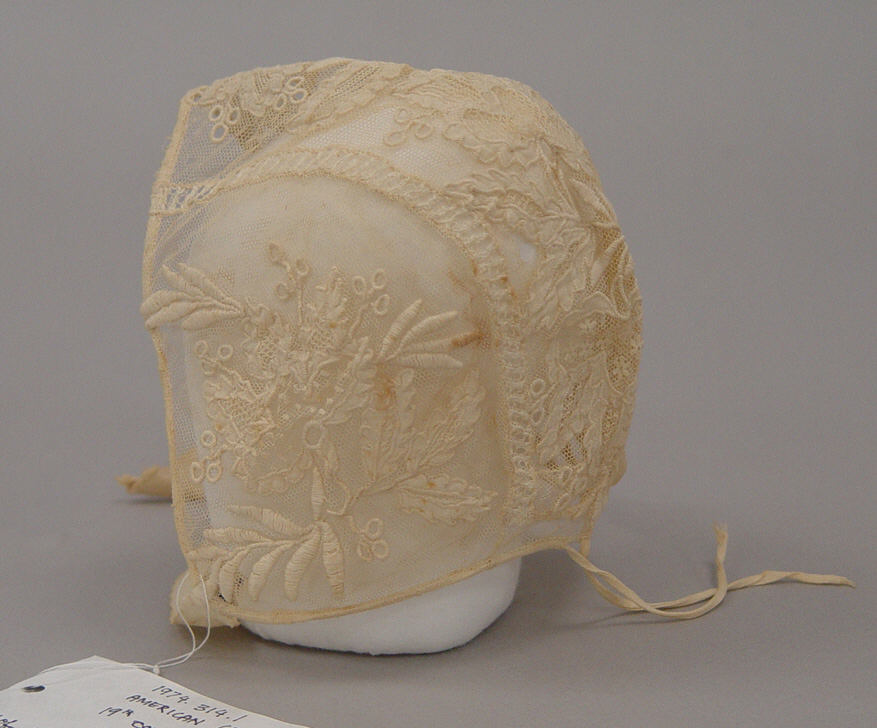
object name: cap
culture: american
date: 1801-1900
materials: cotton